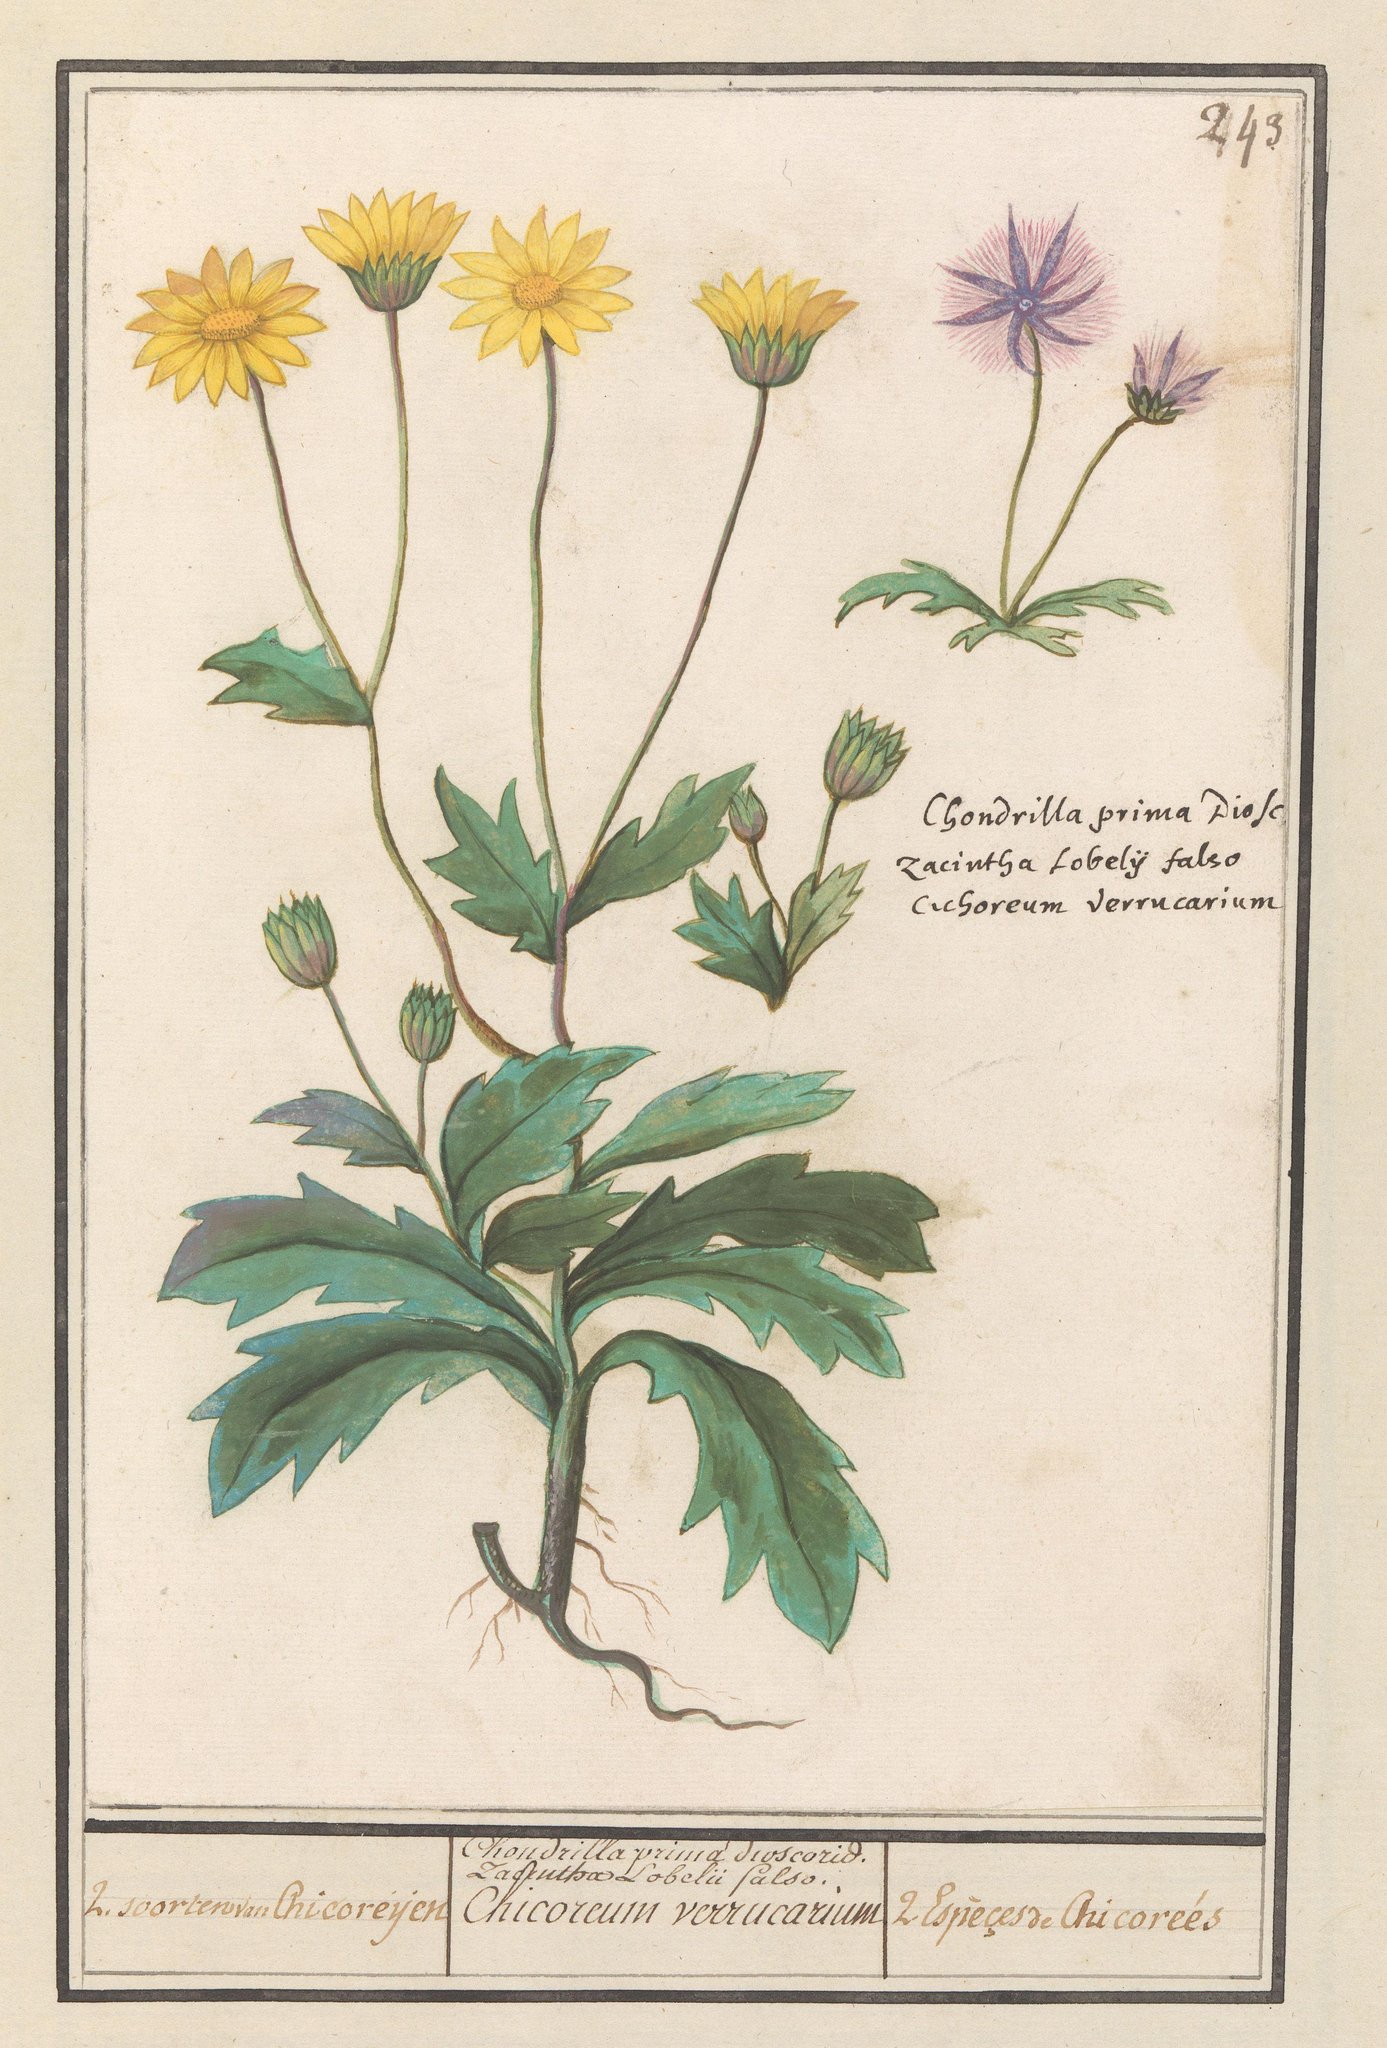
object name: drawing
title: 2 soorten van Chicoreijen / Chondrilla prima dioscorid. Zacinthae Lobelii falso. Chicoreum verrucarium / 2. Espèces de Chicorées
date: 1596-1610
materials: chalk, paint, ink, paper, watercolor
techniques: brush, pen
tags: flowers: chicory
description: Twee (onbekende) bloemen, geel en paars, uit de composietenfamilie. Volgens het onderschrift cichoreien. Genummerd rechtsboven: 243. Rechts de Latijnse namen. Onderdeel van het derde album met tekeningen van bloemen en planten. Tiende van twaalf albums met tekeningen van dieren, vogels en planten bekend rond 1600, gemaakt in opdracht van keizer Rudolf II. Met toelichting in Nederlands, Latijn en Frans.